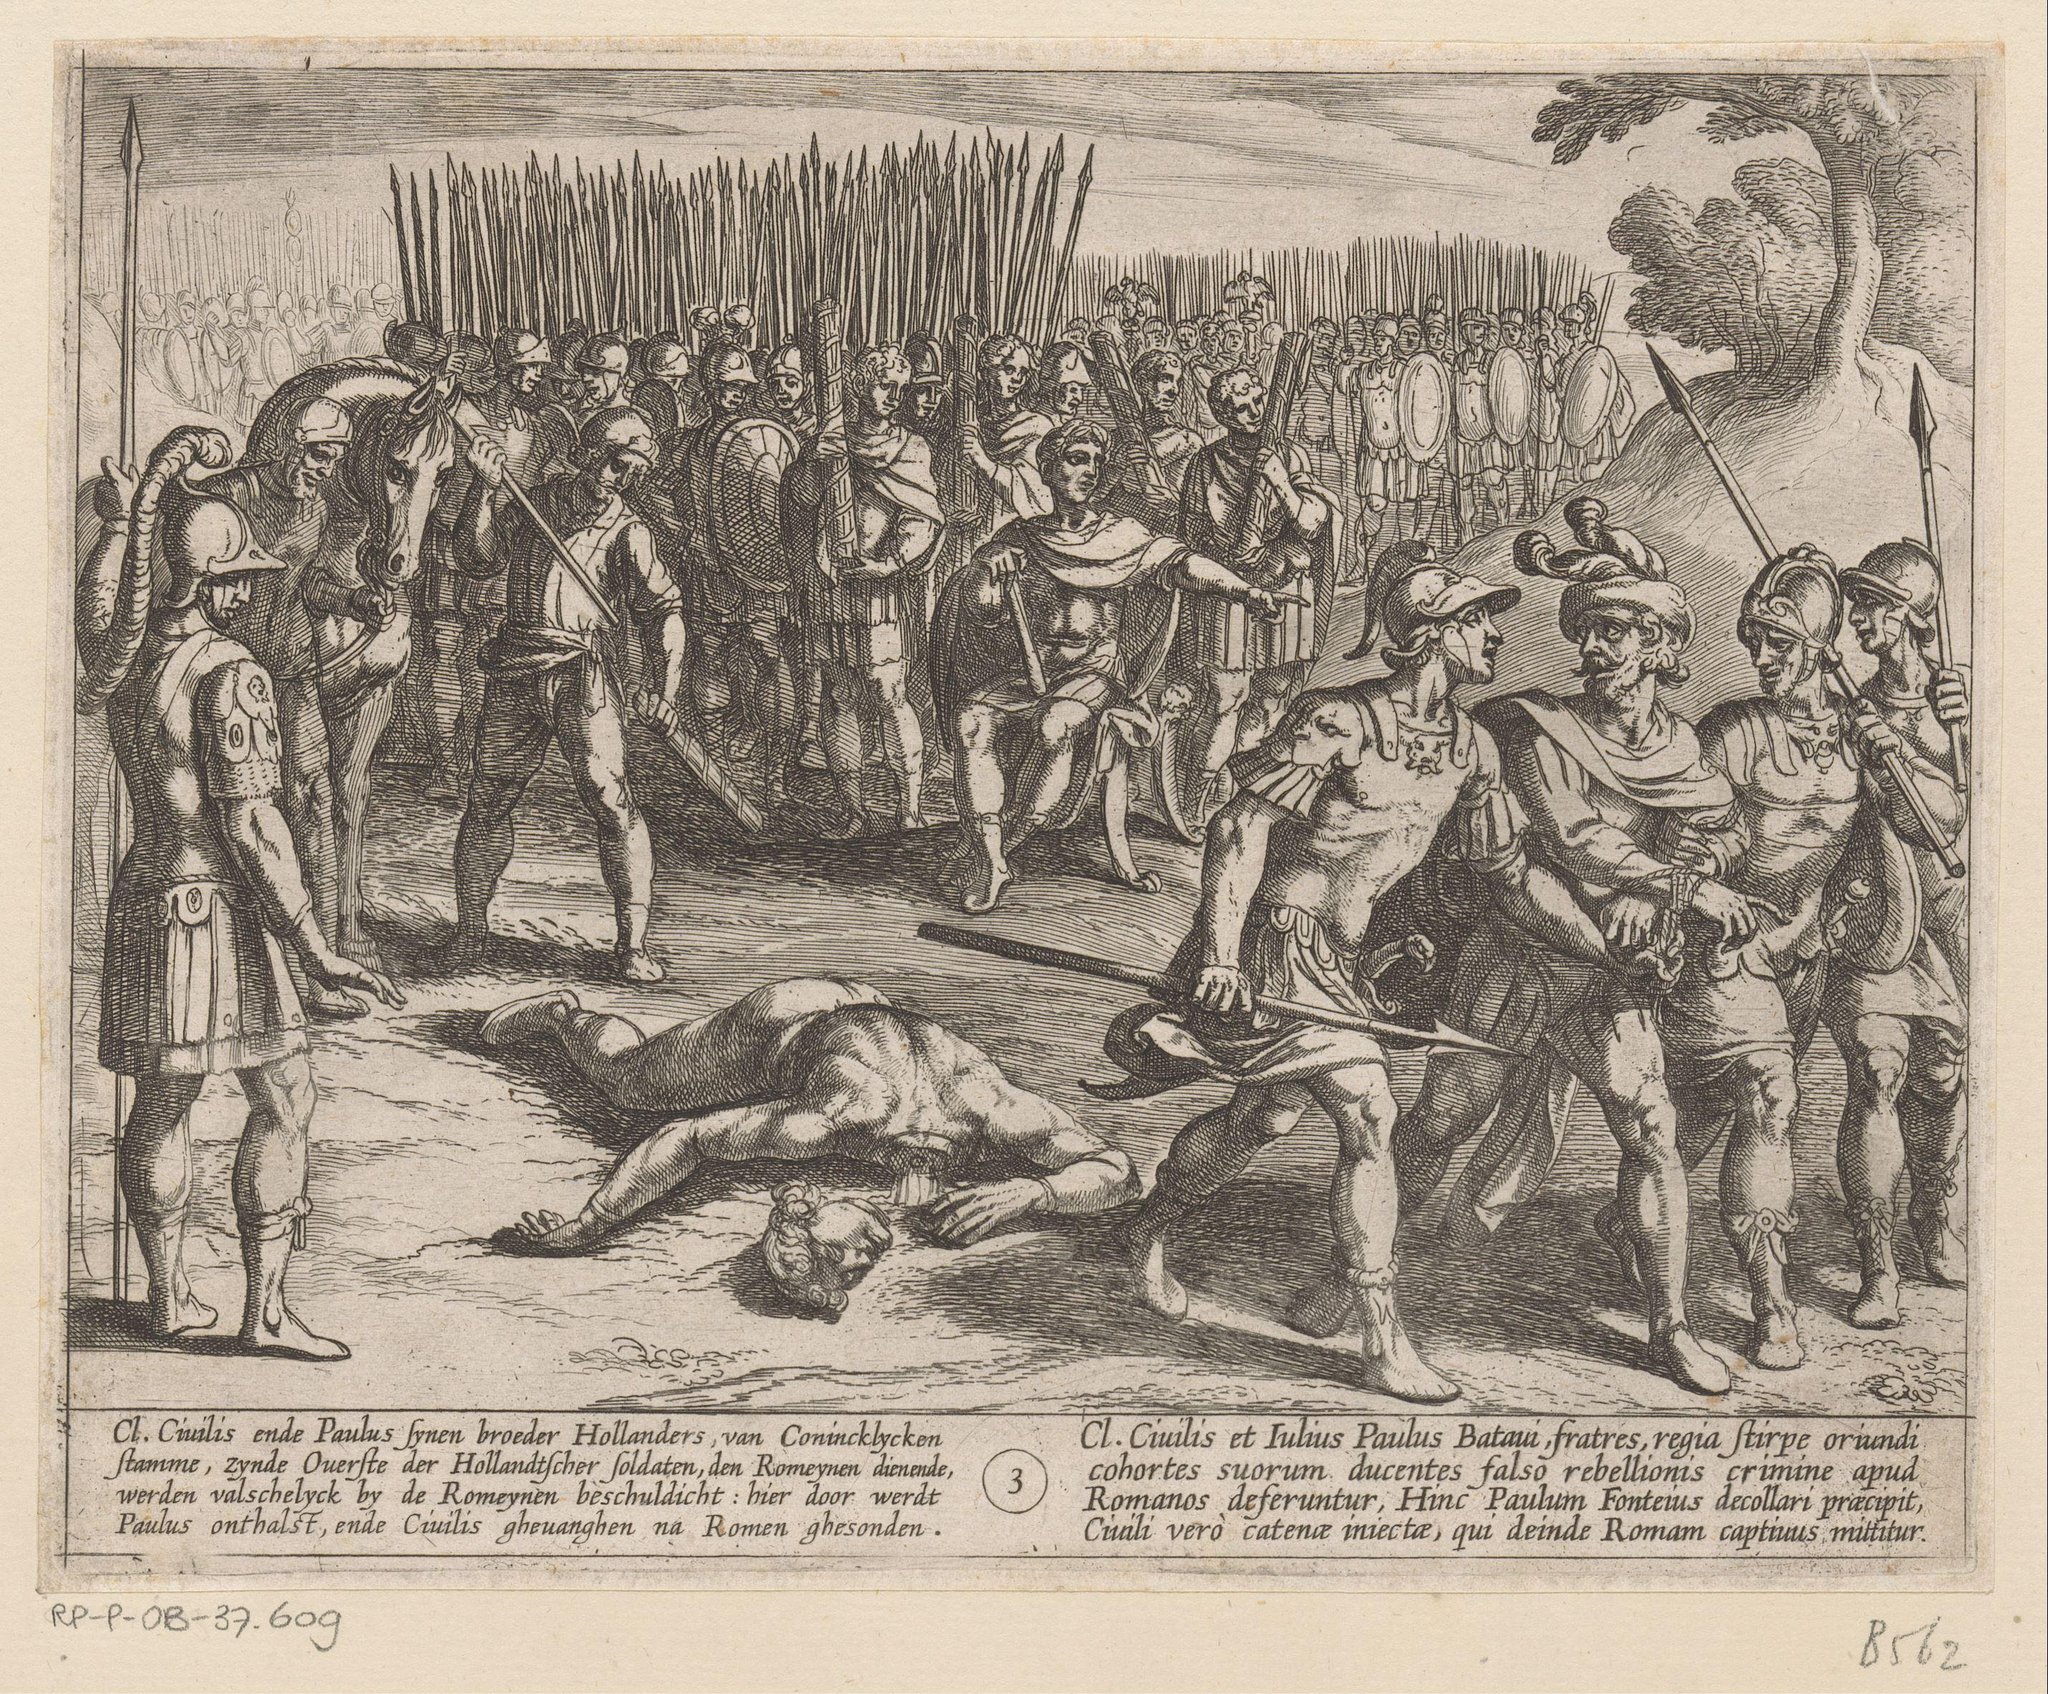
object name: print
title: Batavorum cum Romanis Bellum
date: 1611-1612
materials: paper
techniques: etching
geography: italy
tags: the soldier; the soldier's life, violent death by beheading, (story of) julius claudius civilis, extinct, 'historical' peoples (with name)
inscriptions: collector's mark: Lugt 240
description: Julius Civilis, de leider van de opstand van de Bataven tegen de Romeinen, wordt gearresteerd door Romeinse soldaten. Zijn broer Paulus ligt onthoofd op de grond. Onderschrift in het Nederlands en in het Latijn.